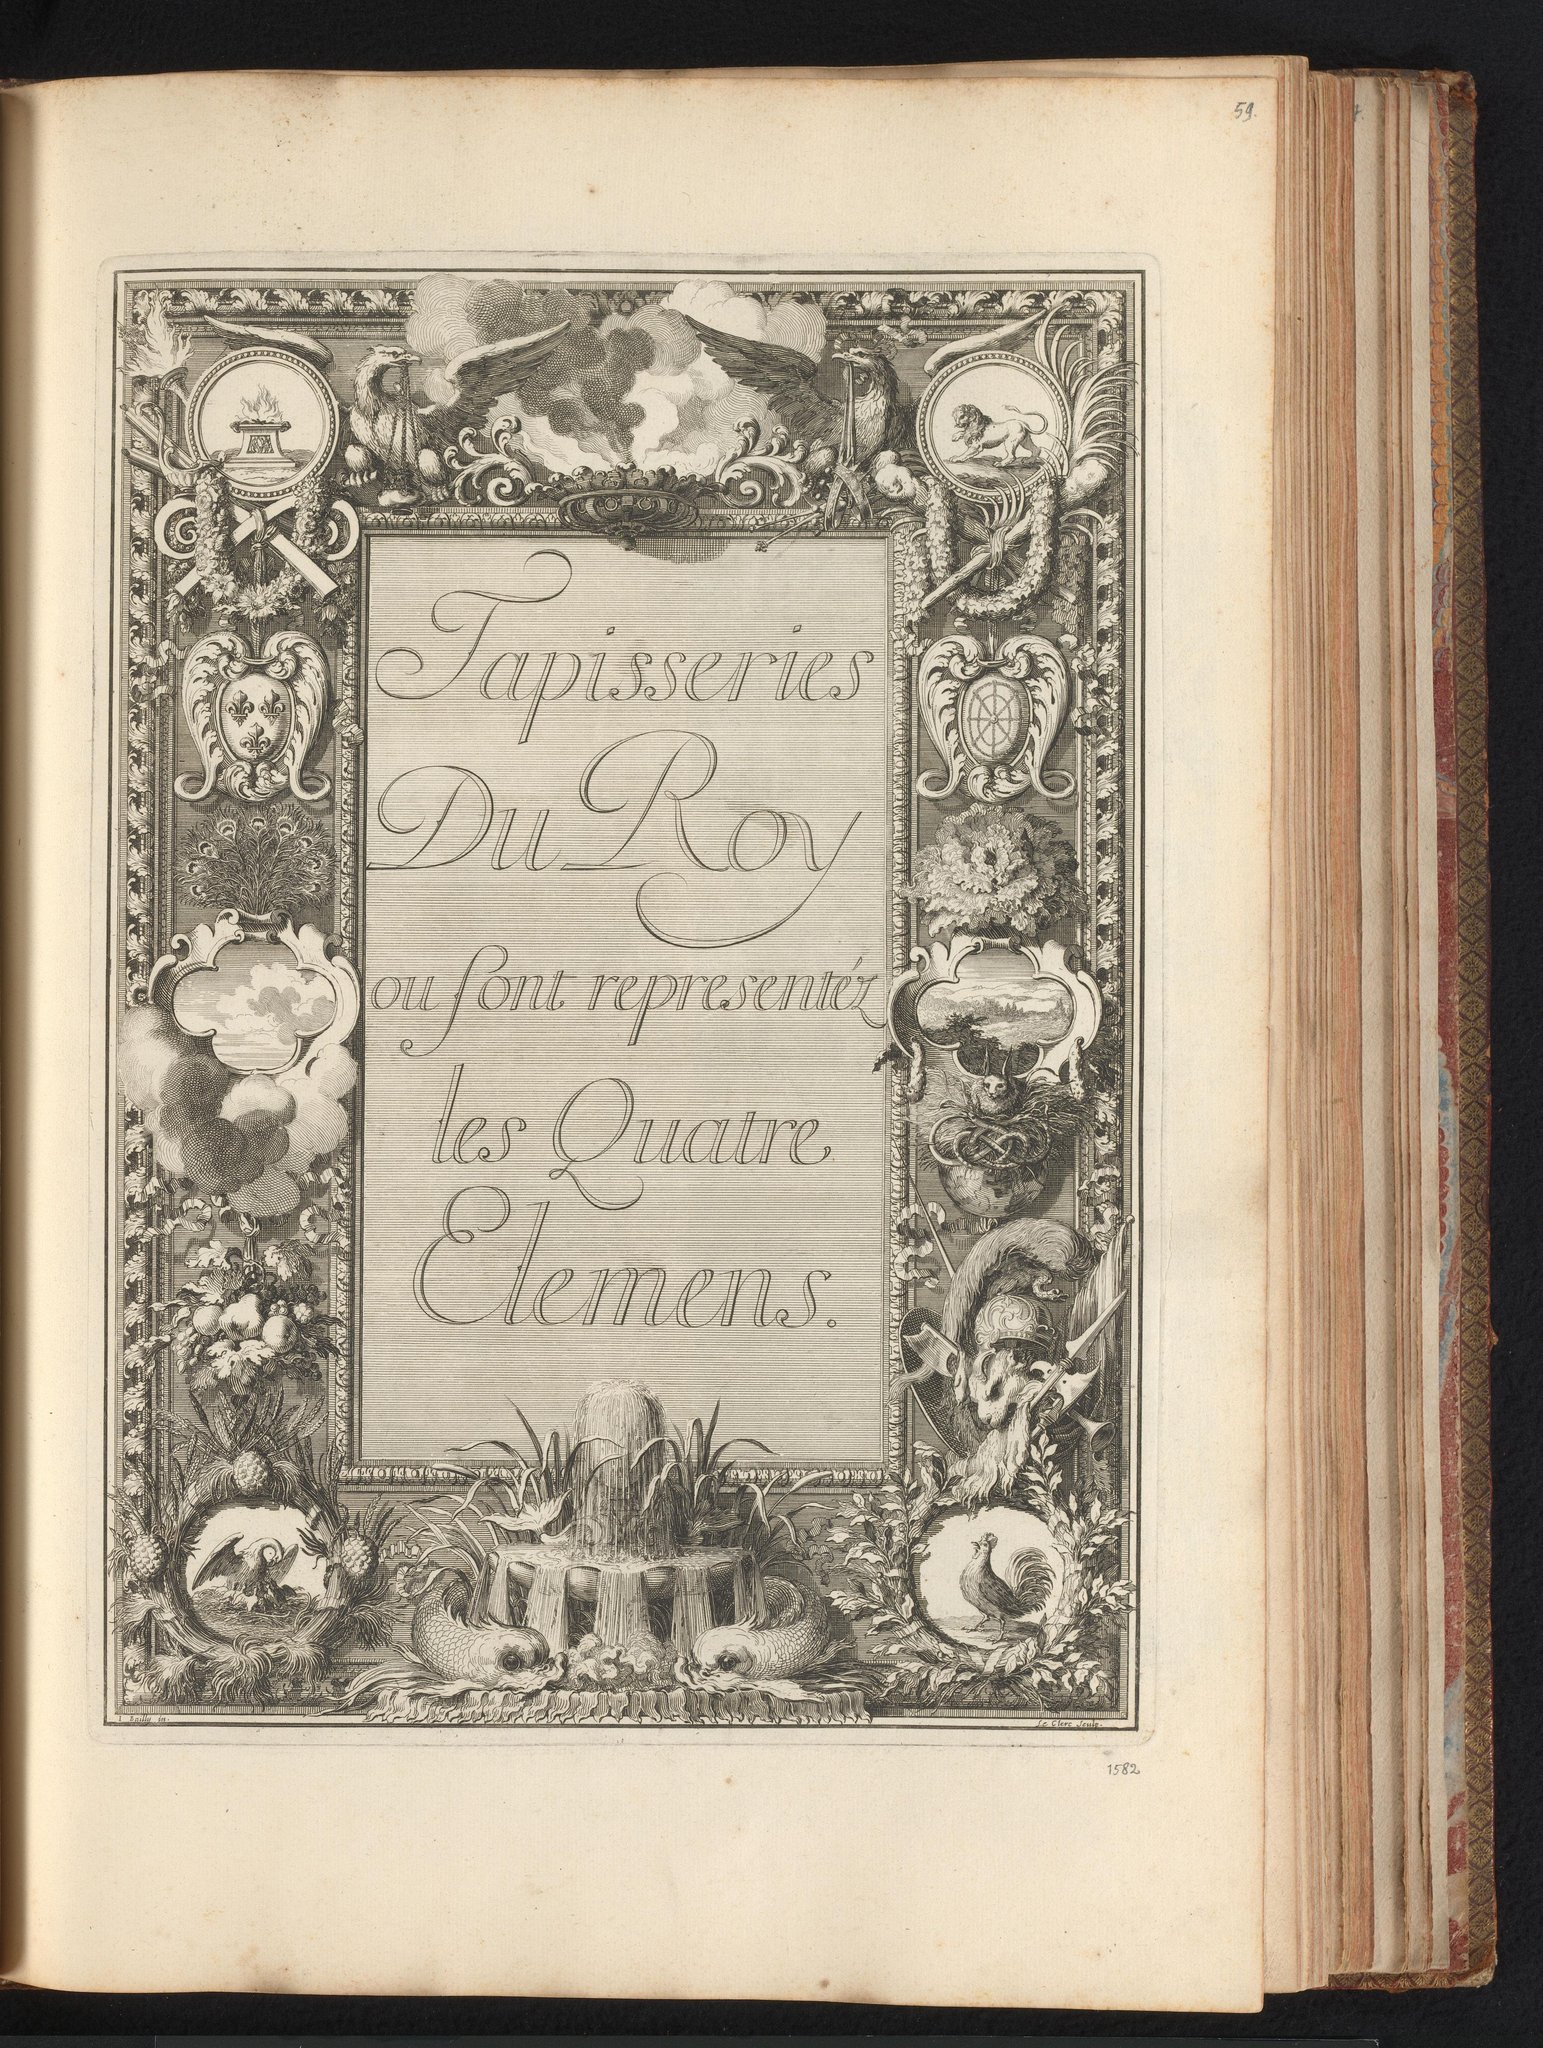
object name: album leaf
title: Ornamentele cartouche met de vier elementen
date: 1670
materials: paper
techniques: engraving, etching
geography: paris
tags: lodewijk xiv (koning van frankrijk), the four elements, and ether, the fifth element, tapestry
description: Titelpagina voor: Félibien, André. Devises pour les tapisseries du Roy, où sont représentez les quatre éléments et les quatre saisons de l'année (...). Parijs: Imprimerie Royale, 1670.